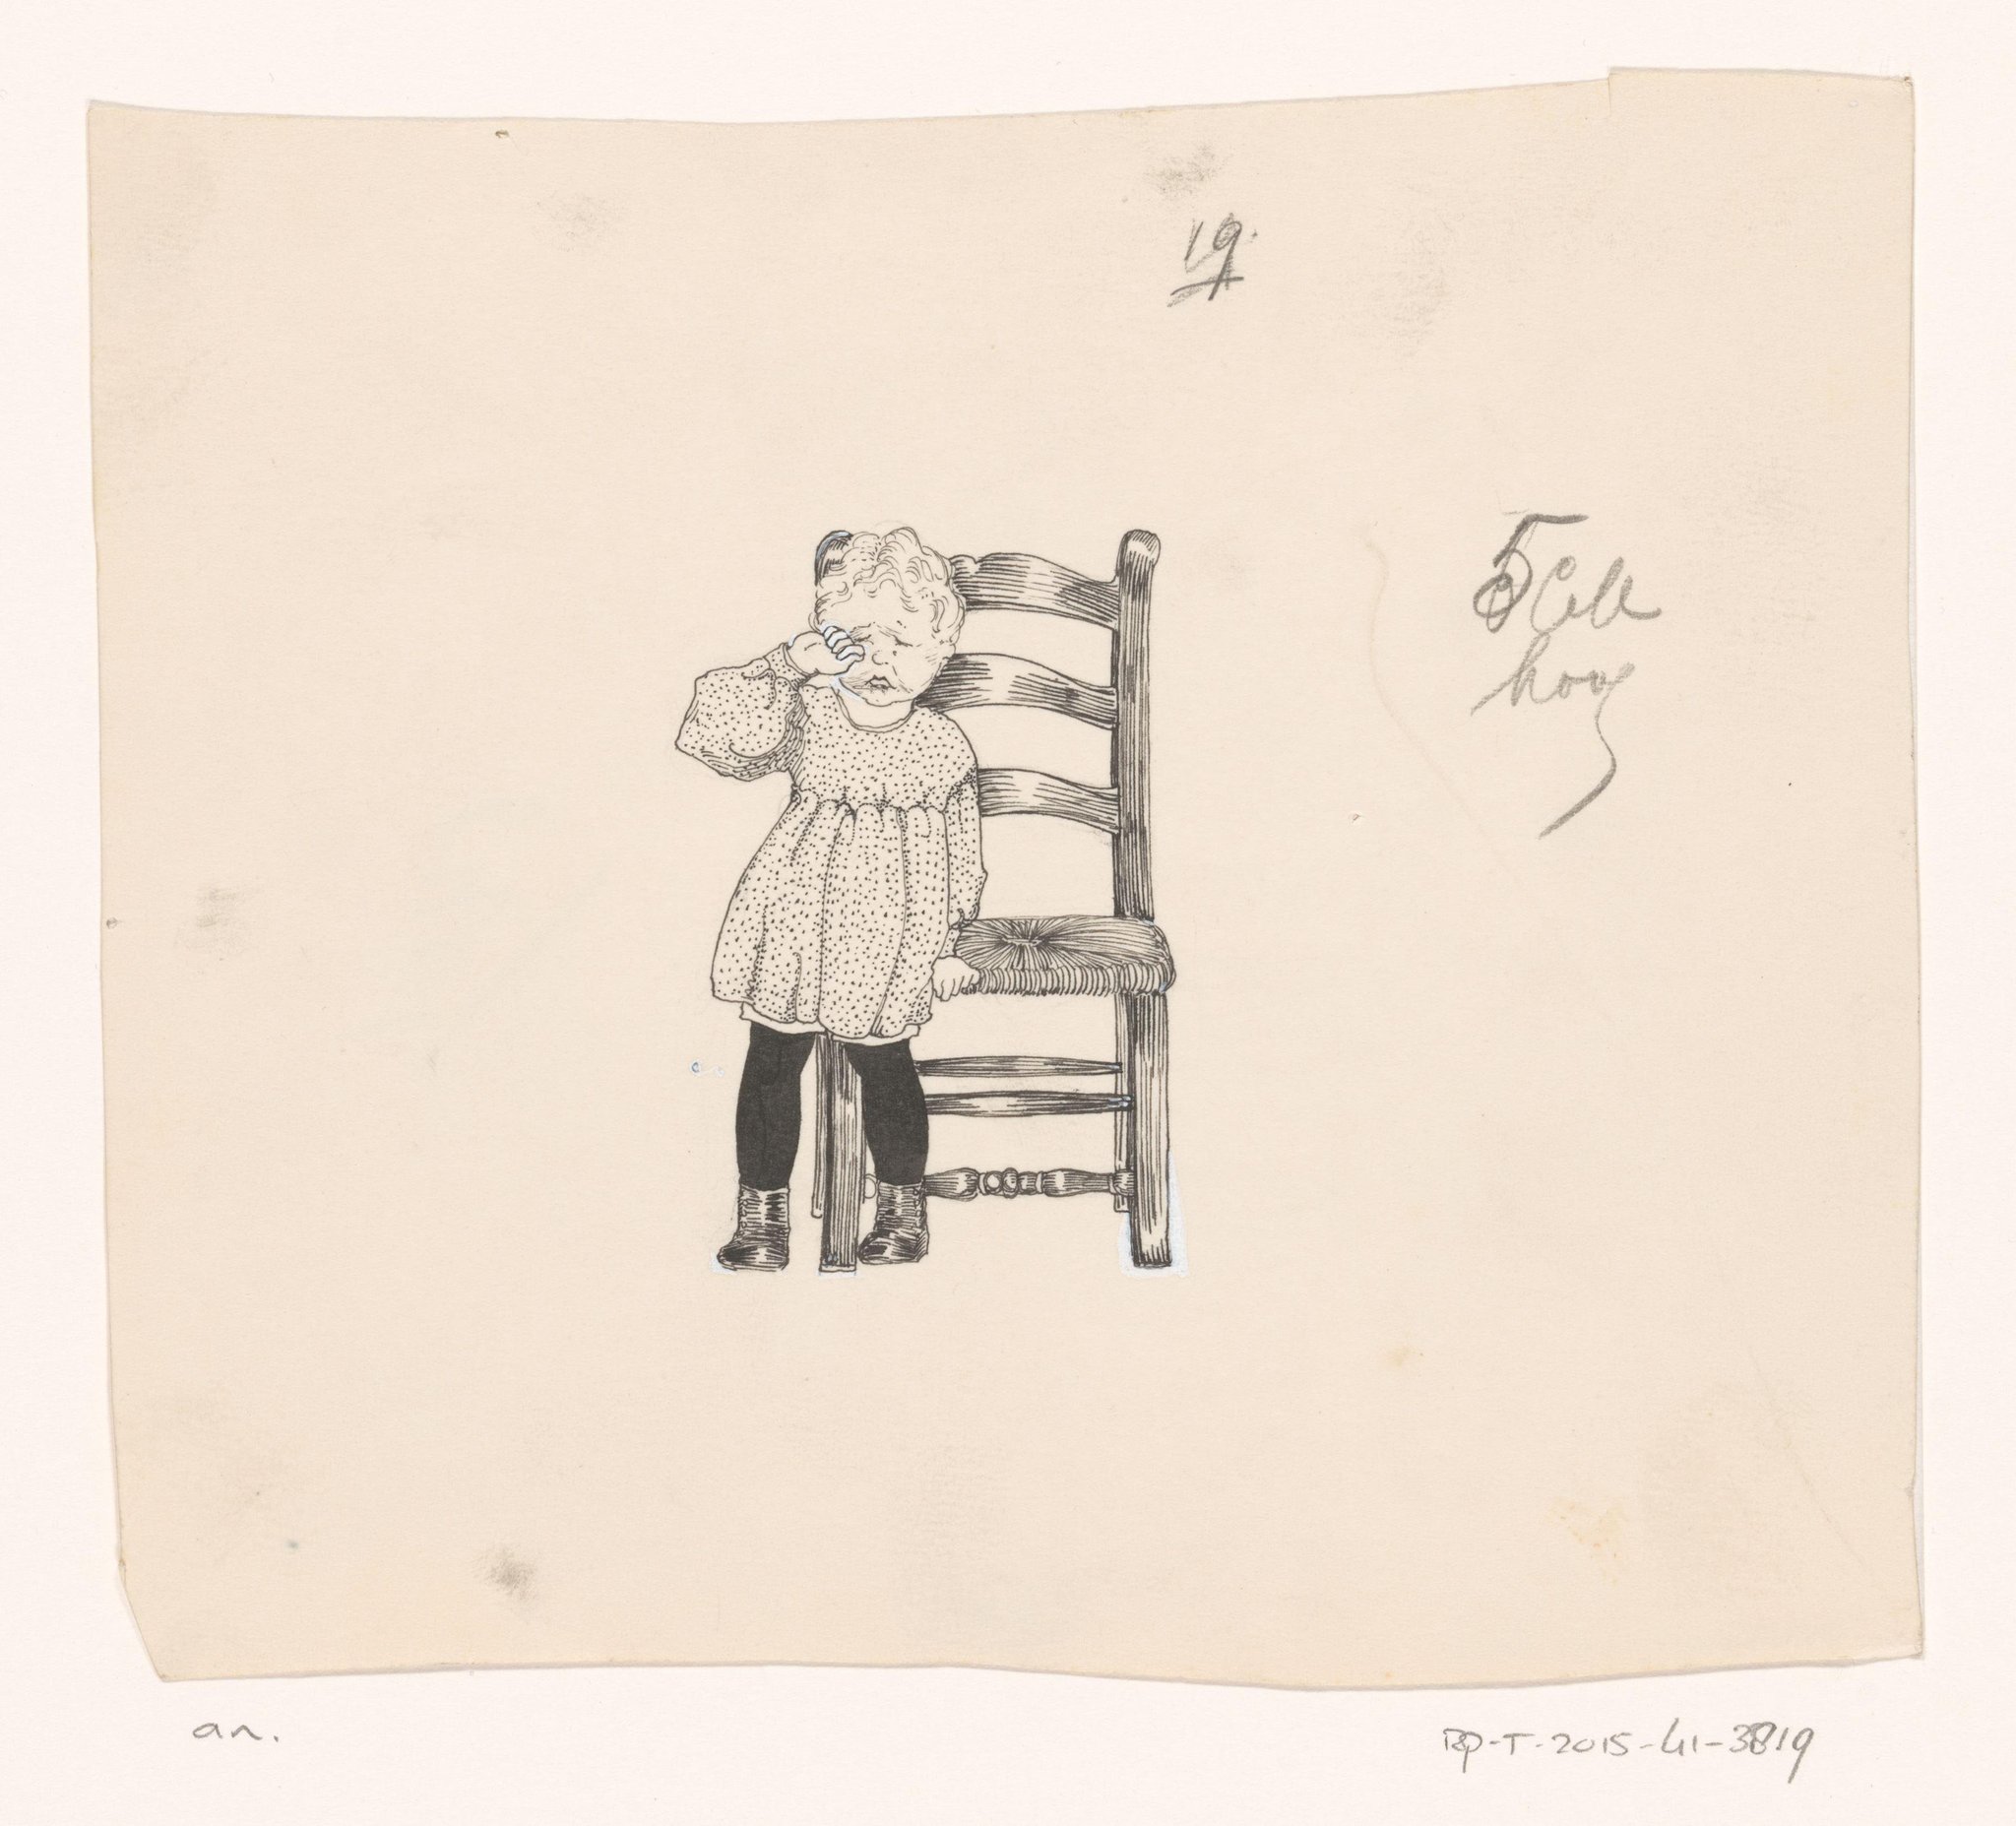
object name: drawing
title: Huilend meisje leunend tegen een stoel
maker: Anonymous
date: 1890-1930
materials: paint, ink, paper, pencil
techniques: brush, pen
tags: weeping, chair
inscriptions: number: ‘19.’, :, collector's mark: Lugt 2228a